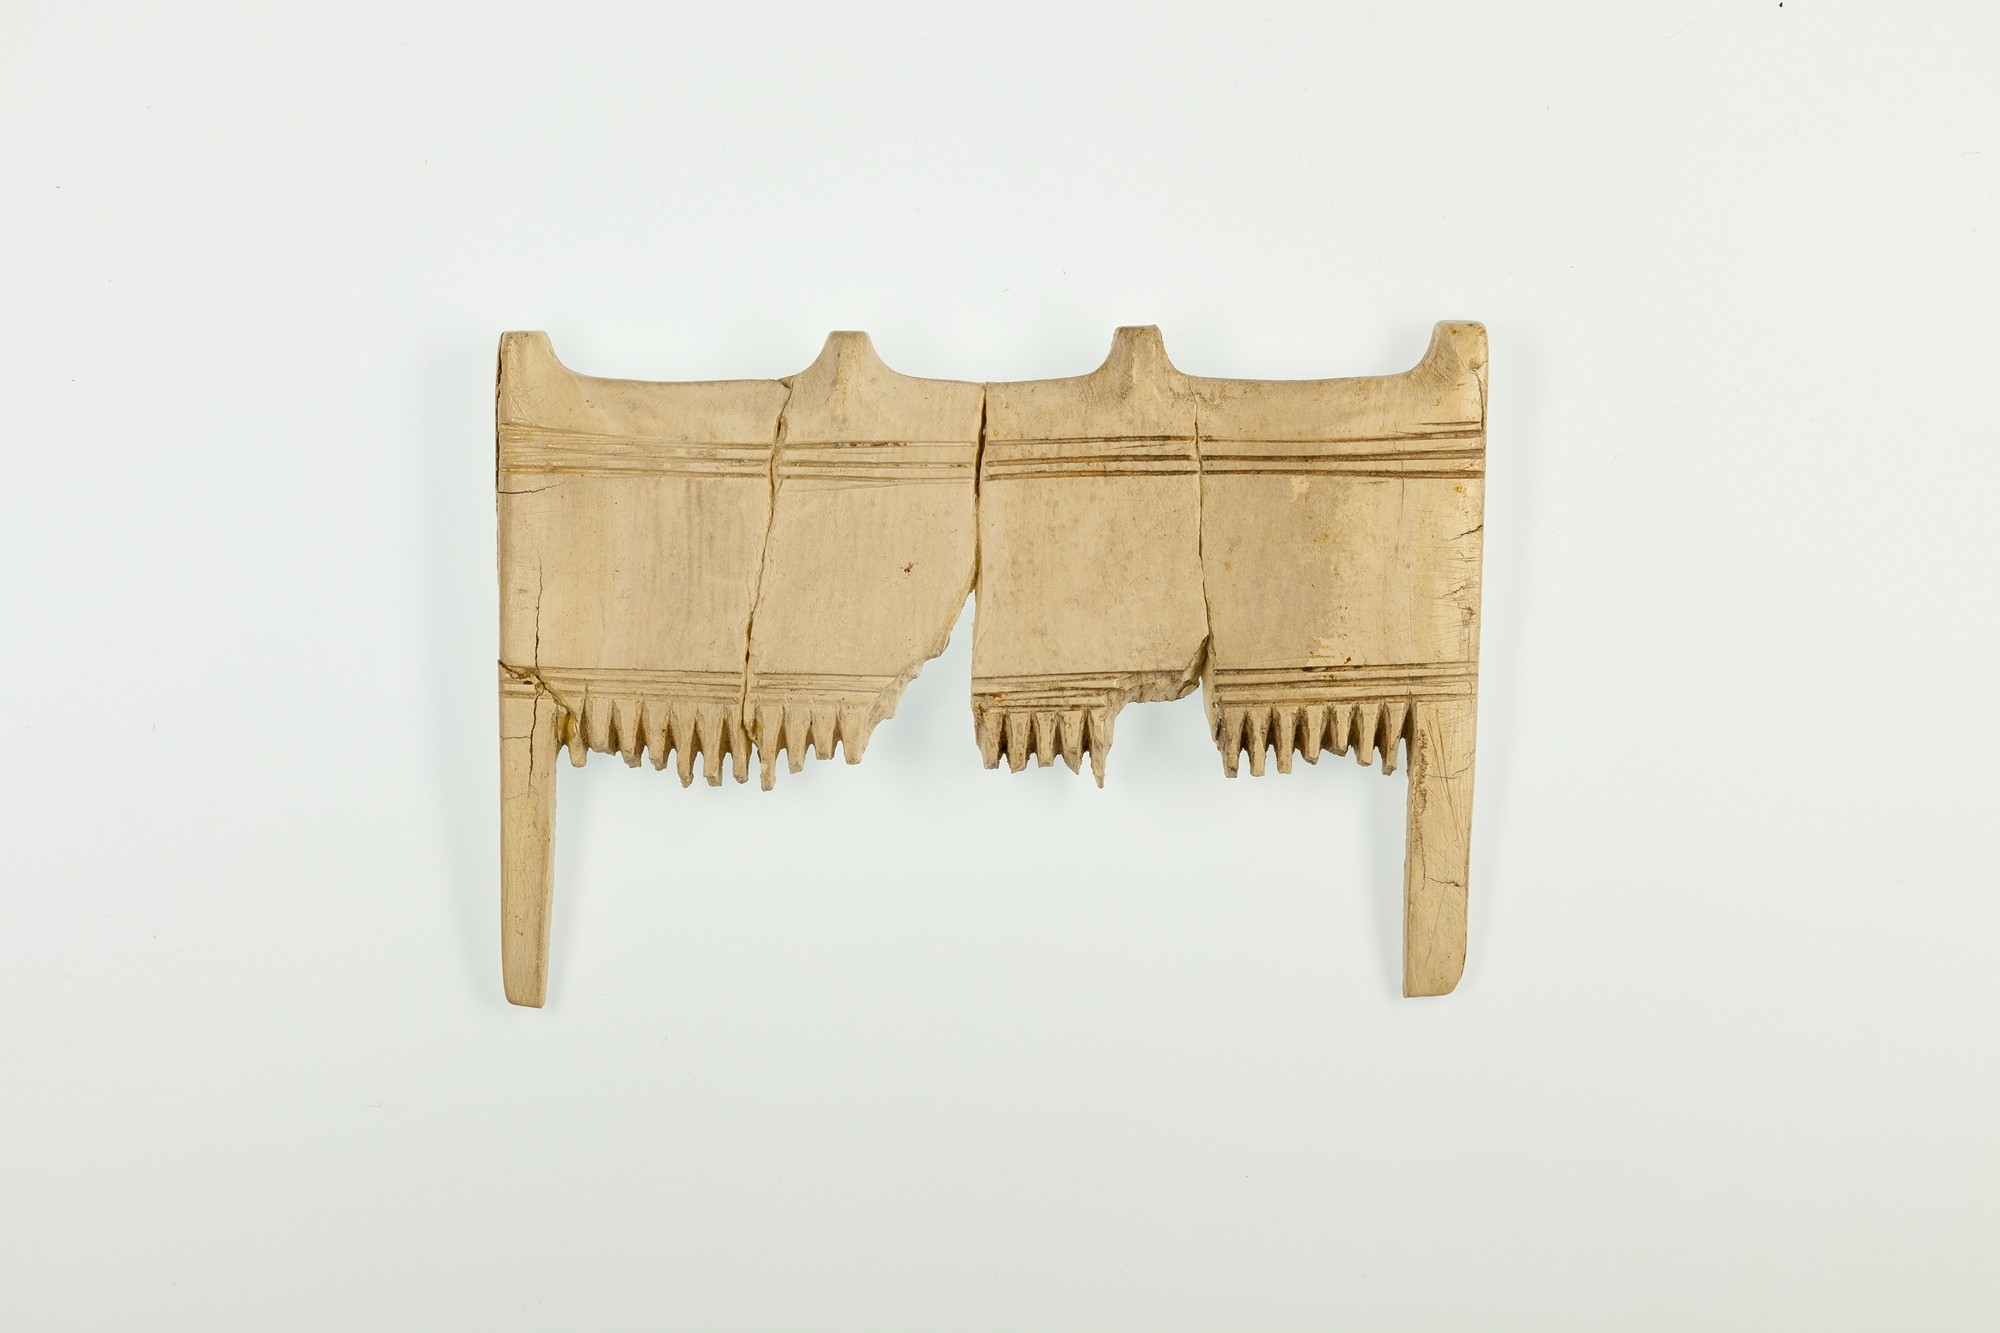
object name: comb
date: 1550-1458 BCE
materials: ivory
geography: egypt